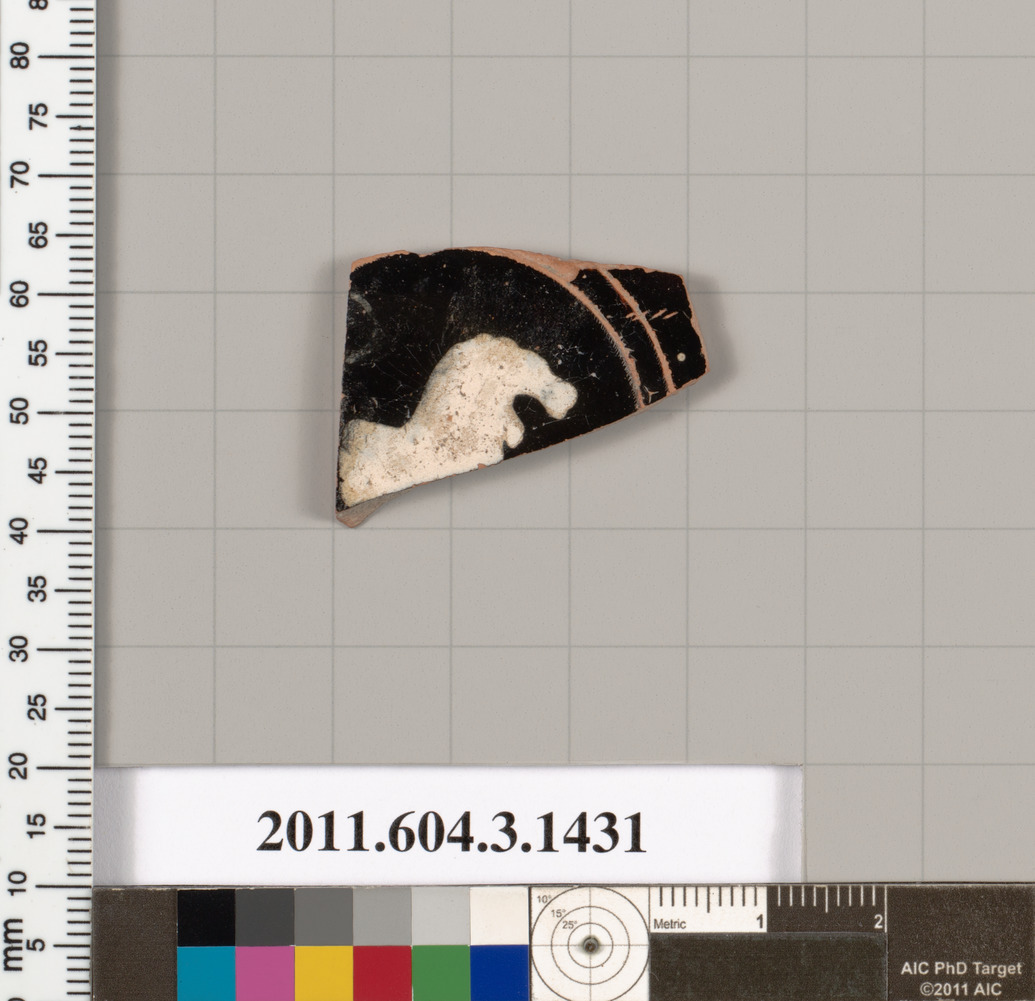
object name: skyphos fragment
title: Terracotta fragment of a skyphos (deep drinking cup)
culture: greek, attic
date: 534-468 BCE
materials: terracotta